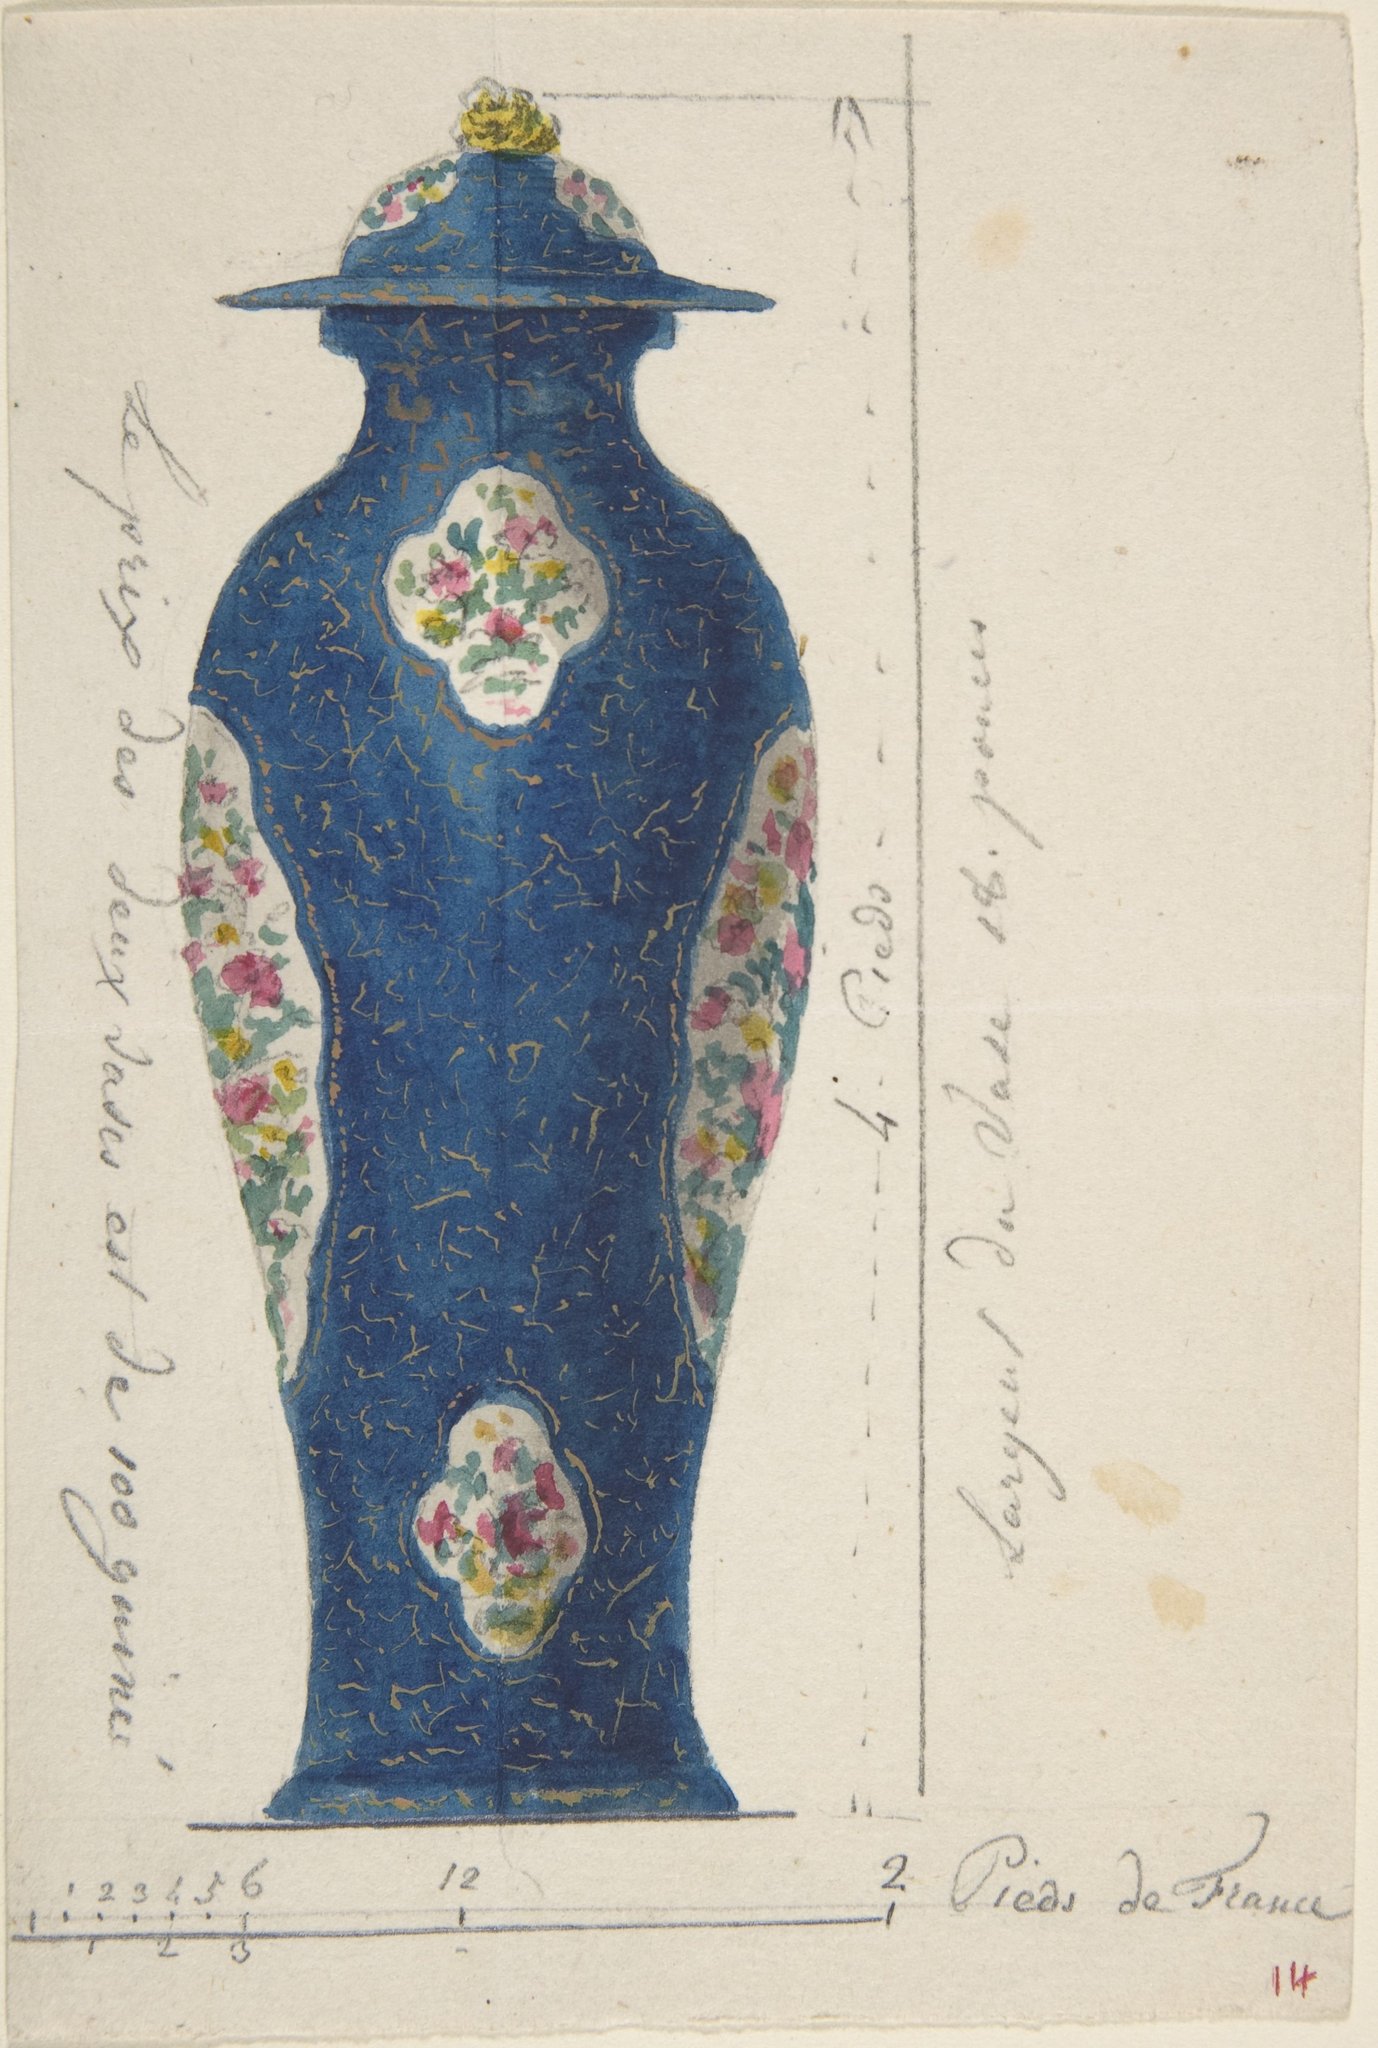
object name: drawing ornament architecture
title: Design for a Vase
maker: anonymous, french, 18th century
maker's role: artist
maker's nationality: french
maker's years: 1700-1800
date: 1770-1785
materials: graphite, watercolor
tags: vases